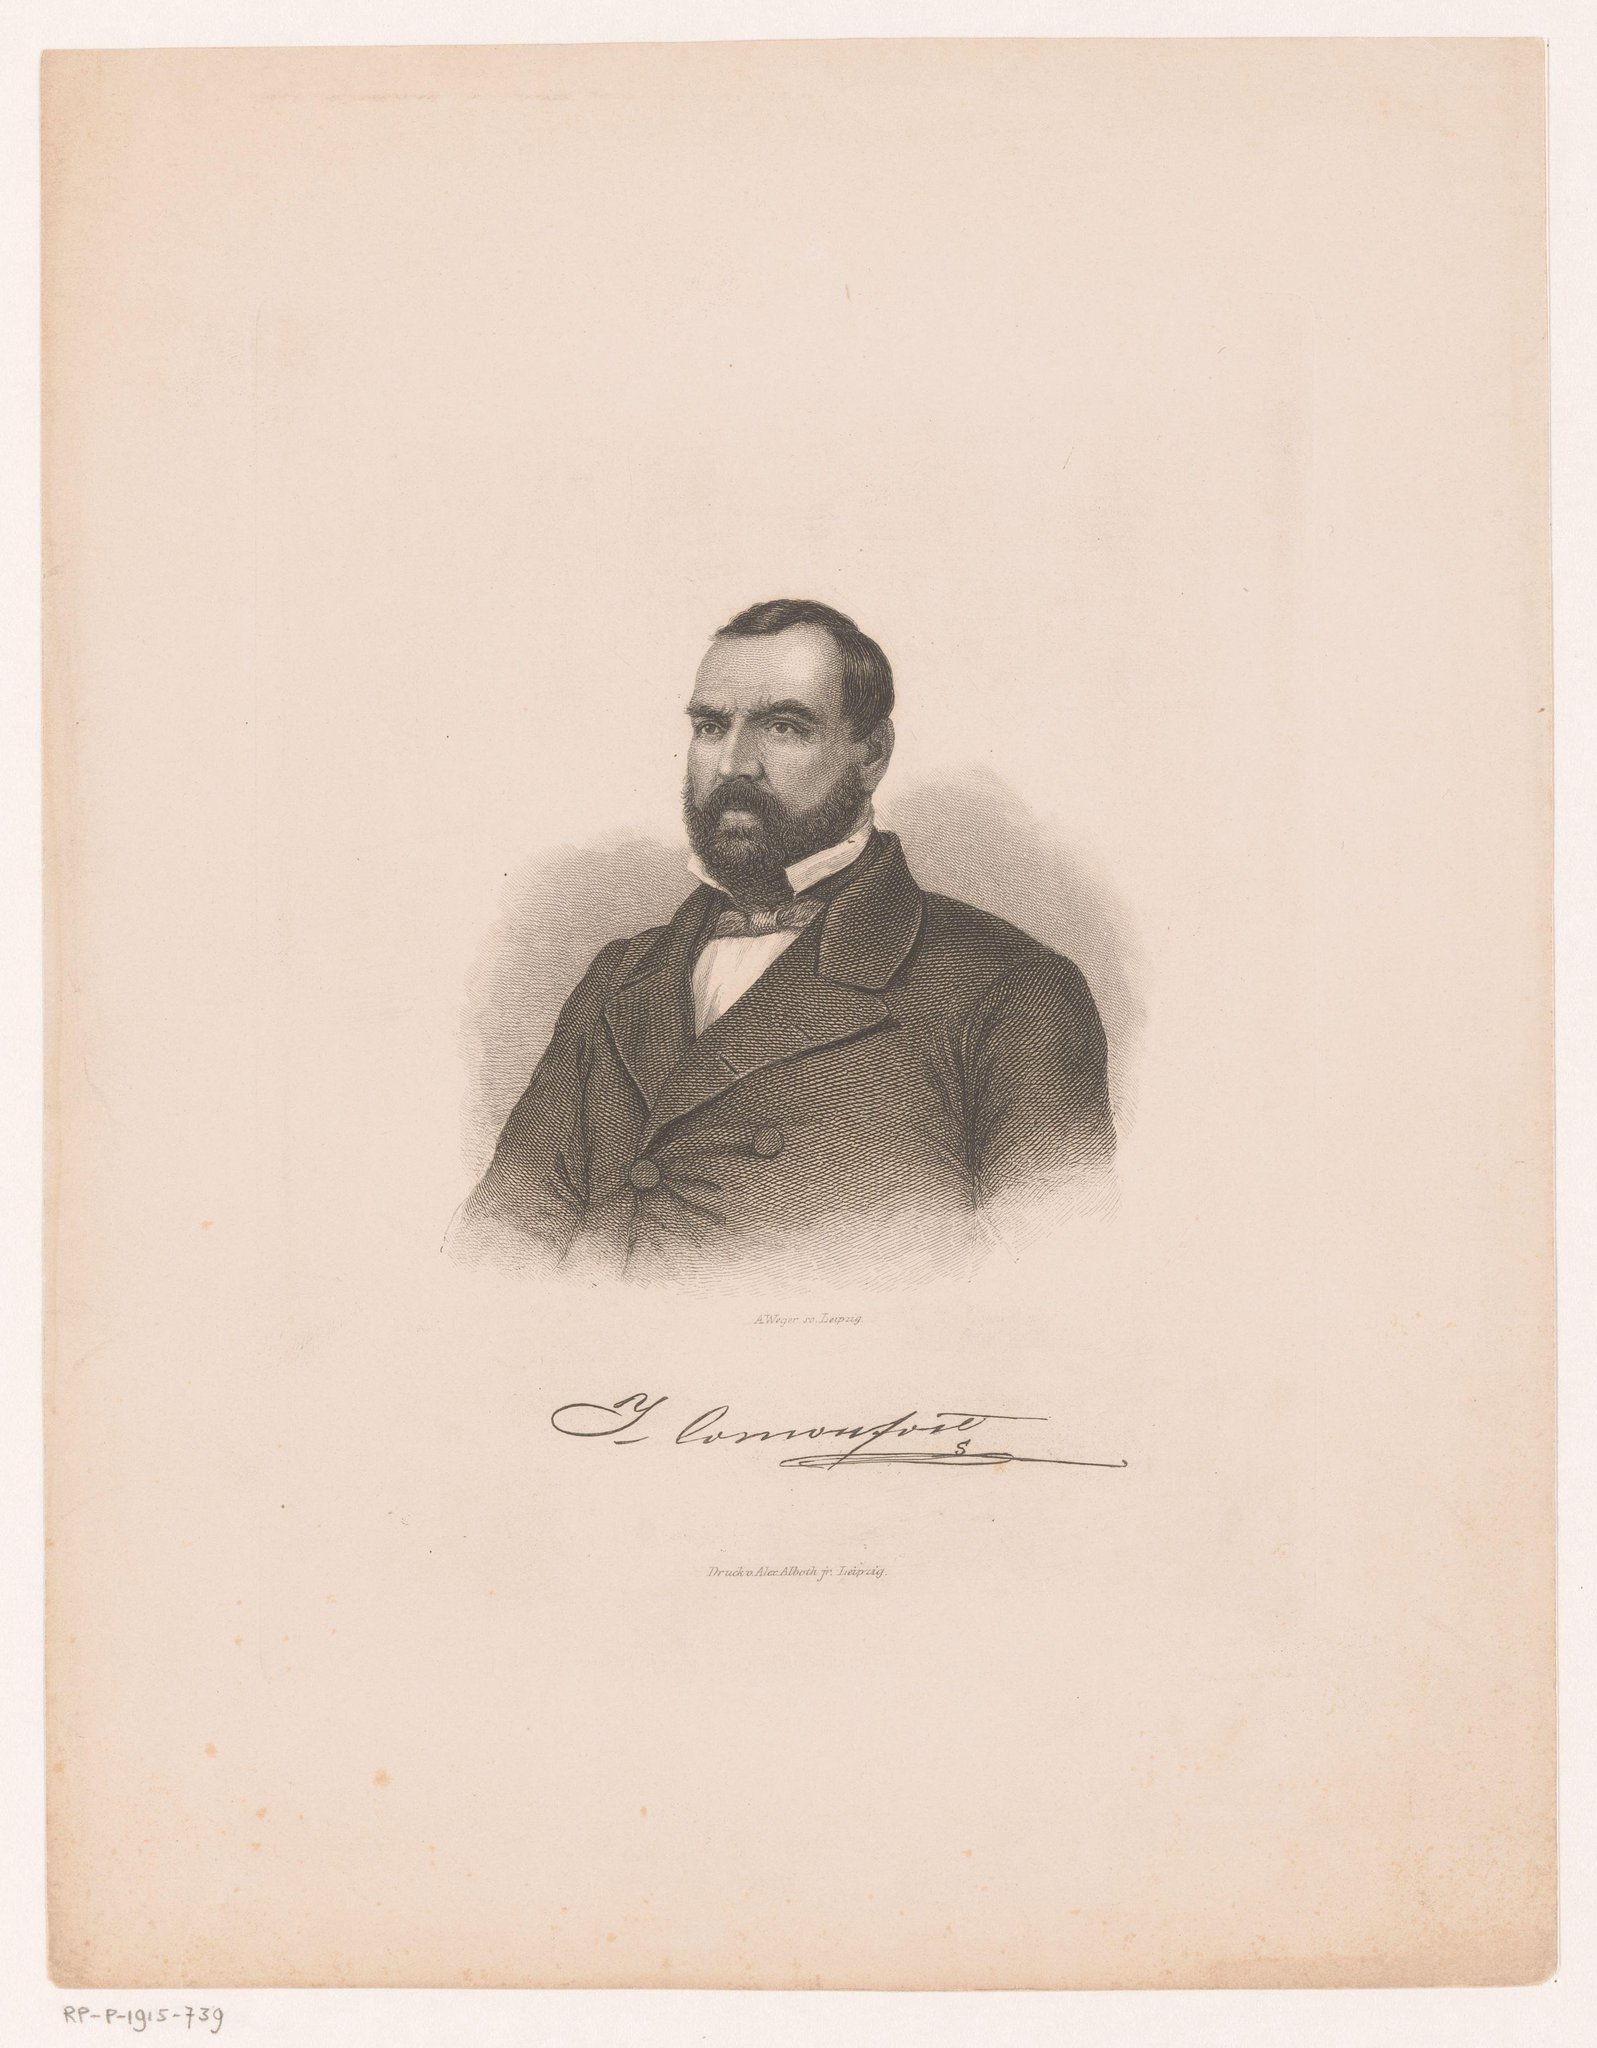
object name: print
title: Portret van Ignacio Comonfort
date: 1849-1892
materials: paper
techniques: engraving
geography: leipzig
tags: historical persons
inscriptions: collector's mark: Lugt 2228